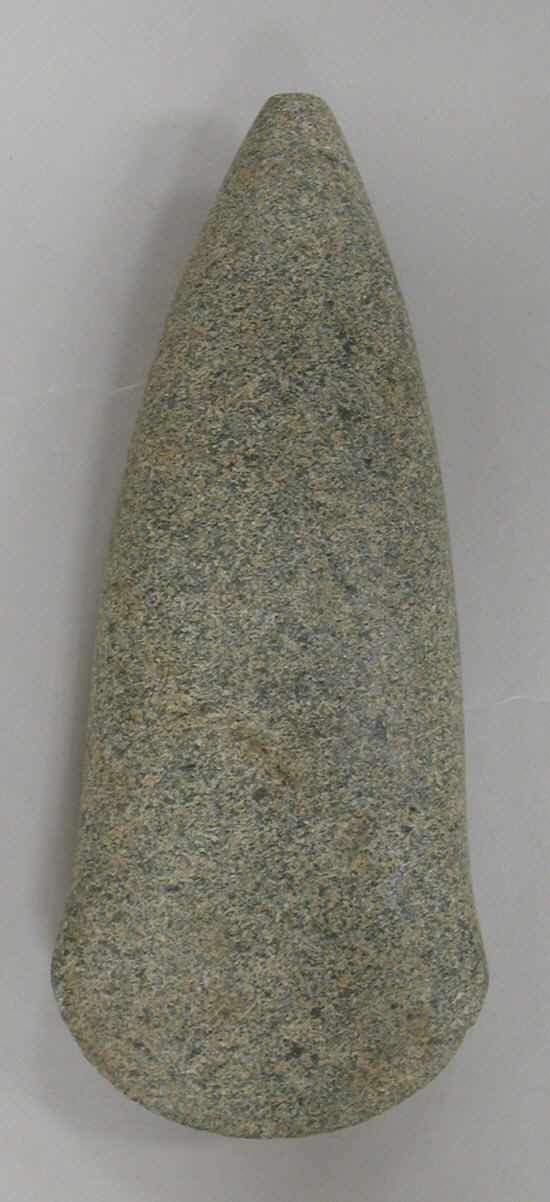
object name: celt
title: Stone Celt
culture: costa rican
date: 1501-1600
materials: stone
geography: costa rica